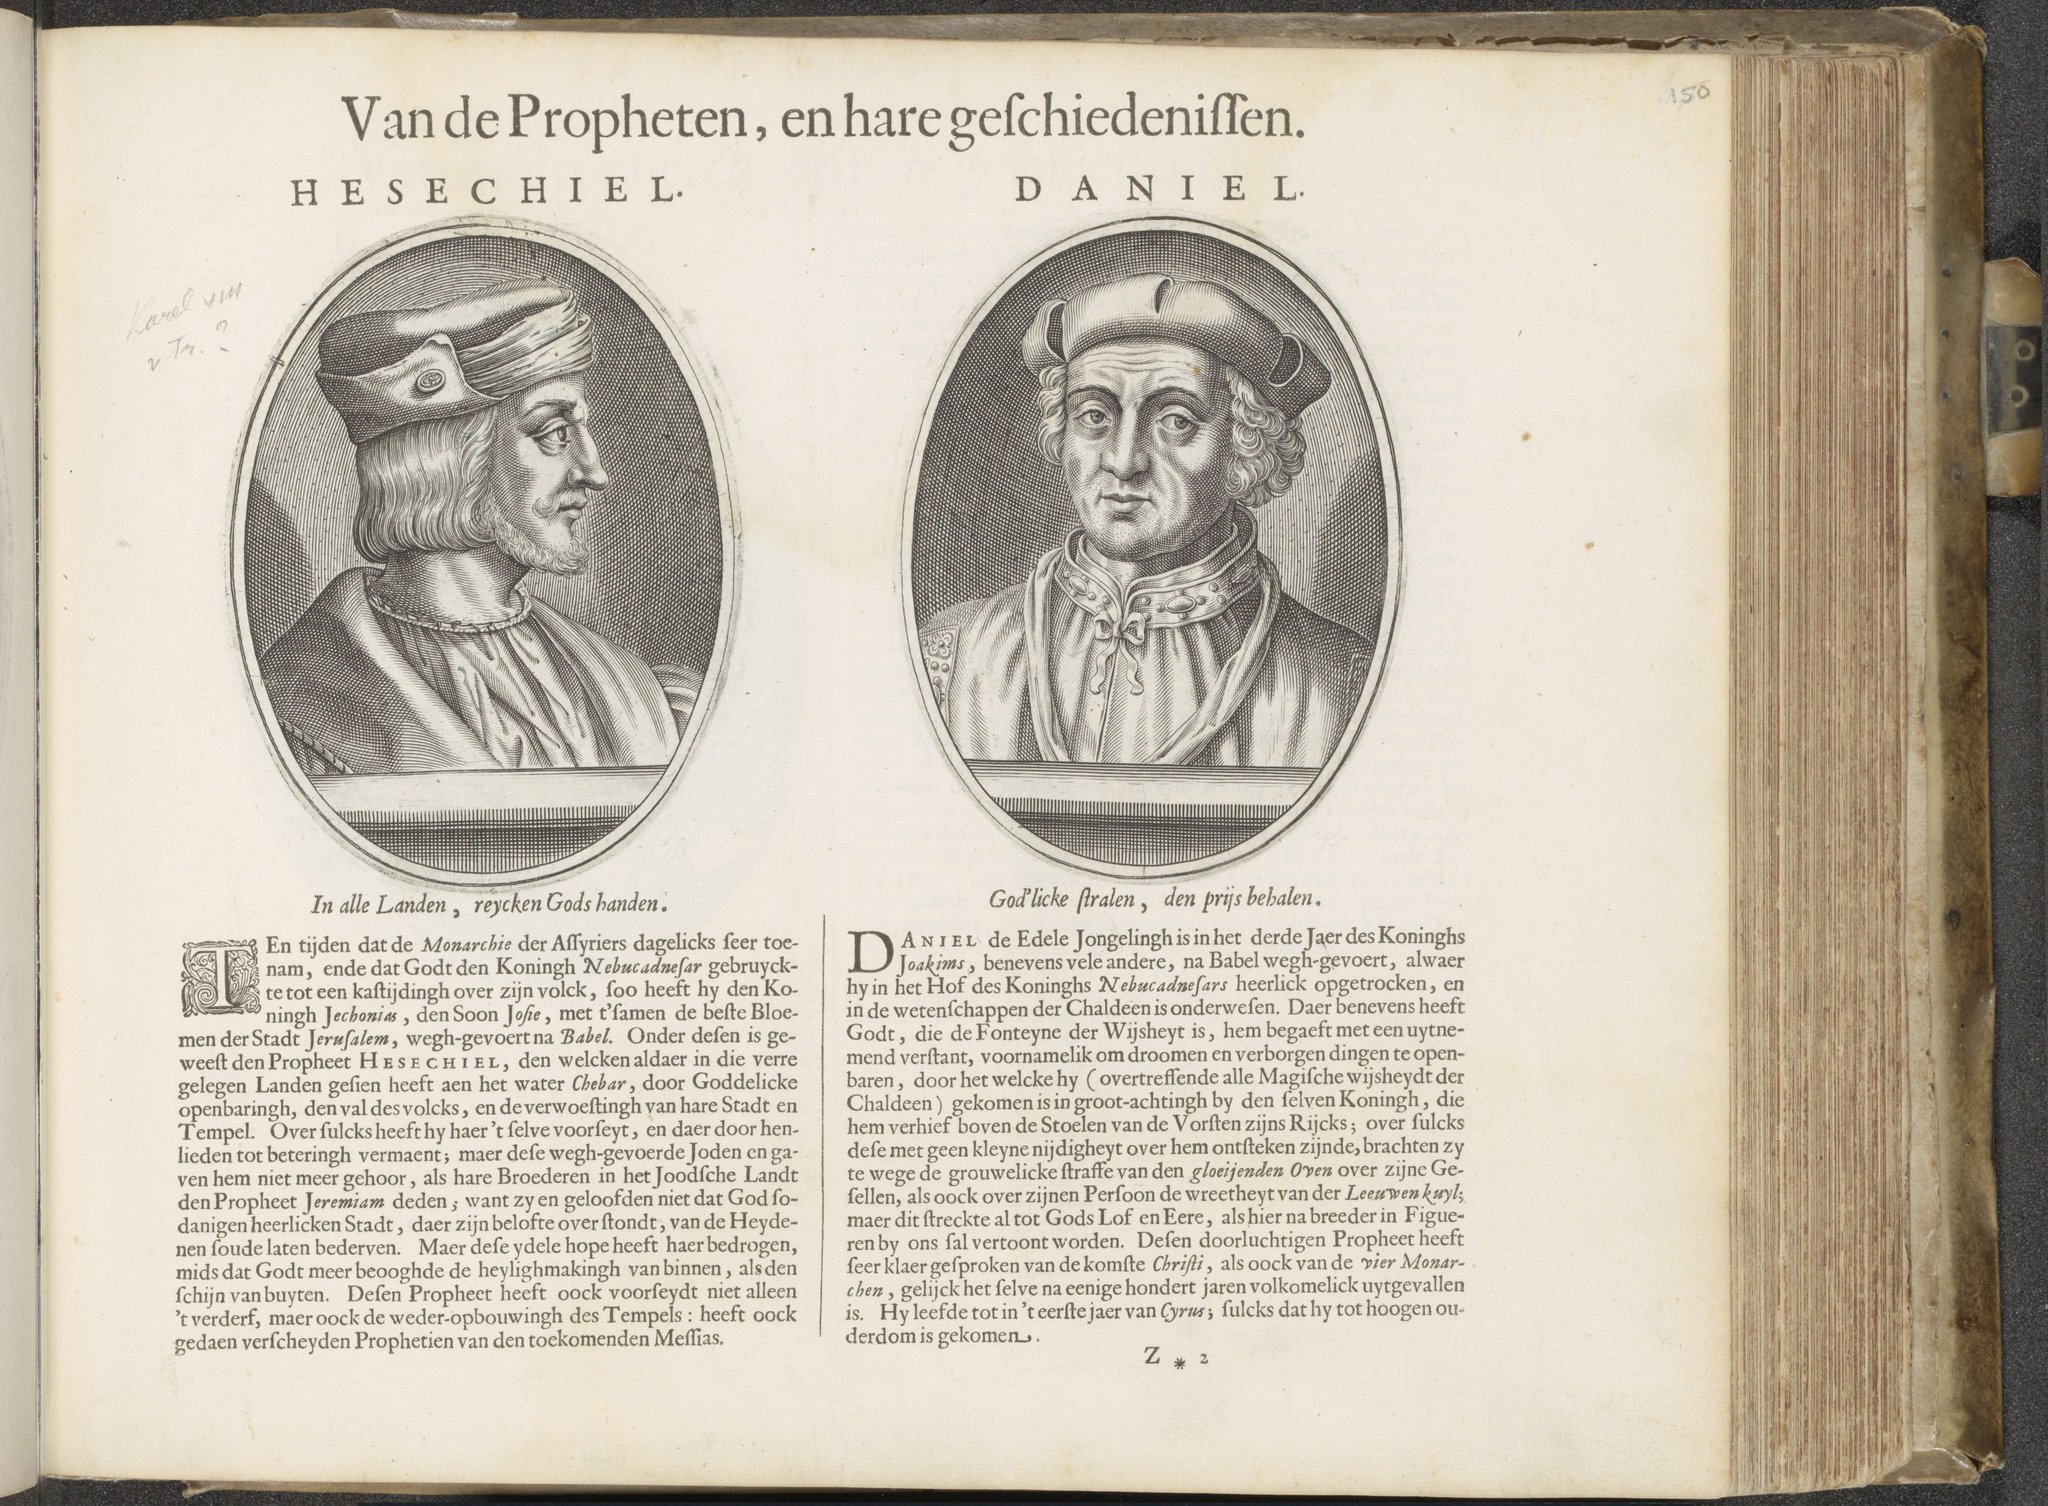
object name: album leaf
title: Portretten van de profeten Ezechiël en Daniël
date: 1610-1625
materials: paper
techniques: engraving, letterpress printing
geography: amsterdam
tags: politician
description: Portretten van Gaston de Foix en Giangiacomo Trivulzio, in dit album gebruikt als afbeeldingen van respectievelijk de profeten Ezechiël en Daniël. De begeleidende tekst begint met een kleine gedecoreerde initiaal I. Het blad maakt deel uit van een album.